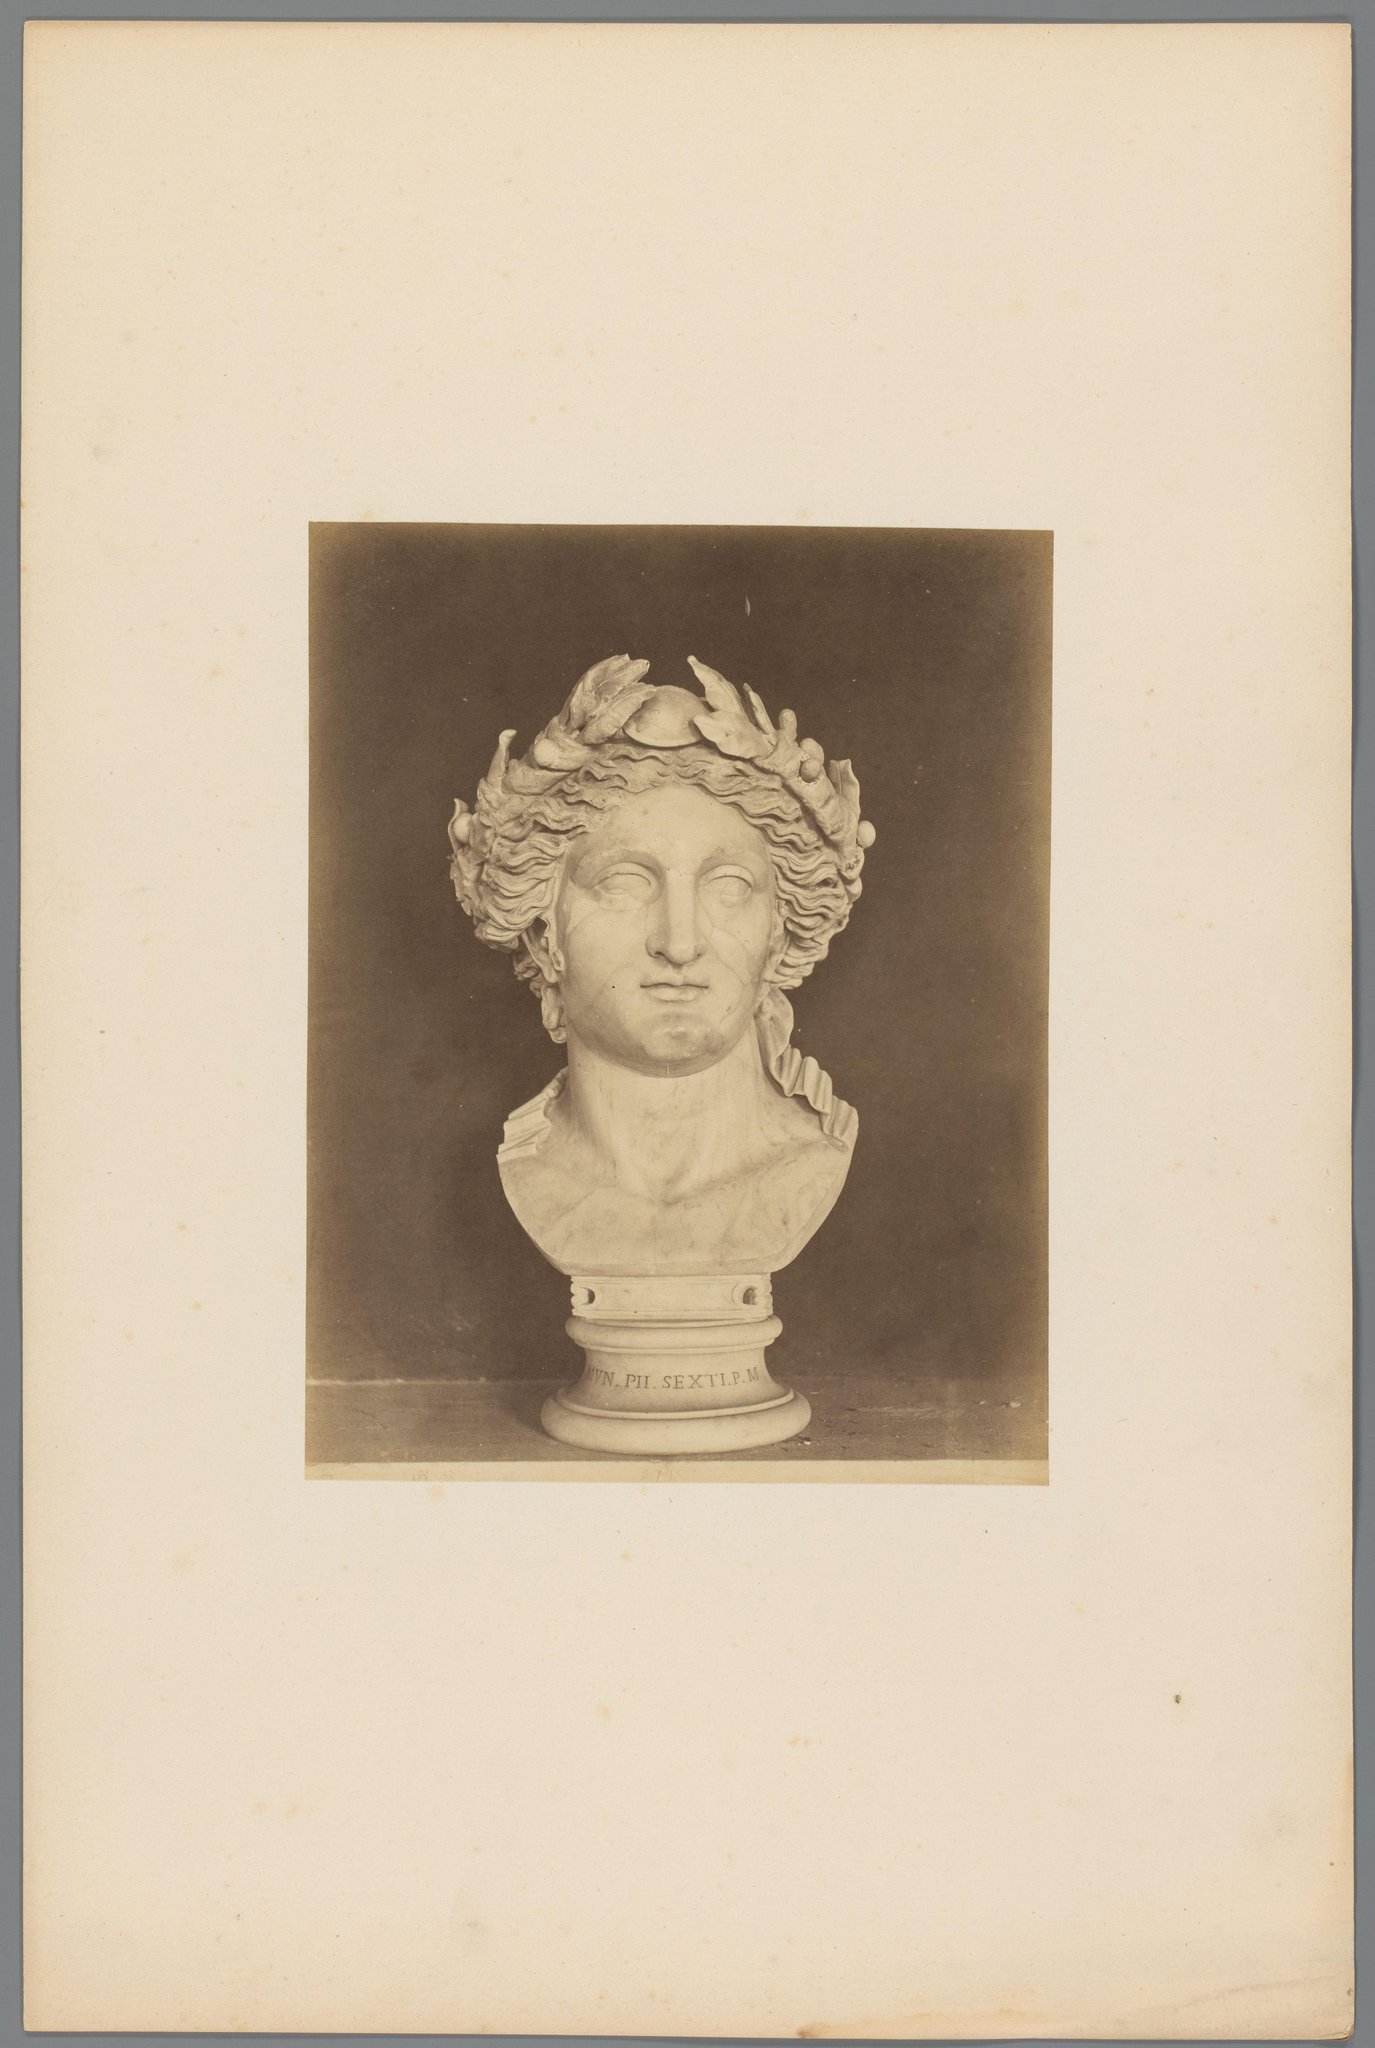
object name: photograph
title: Buste van keizer Nero in de Vaticaanse Musea, Italië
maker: Anonymous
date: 1851-1900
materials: cardboard, paper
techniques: albumen print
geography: vatican city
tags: head (human), piece of sculpture, reproduction of a piece of sculpture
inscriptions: number: ‘216’